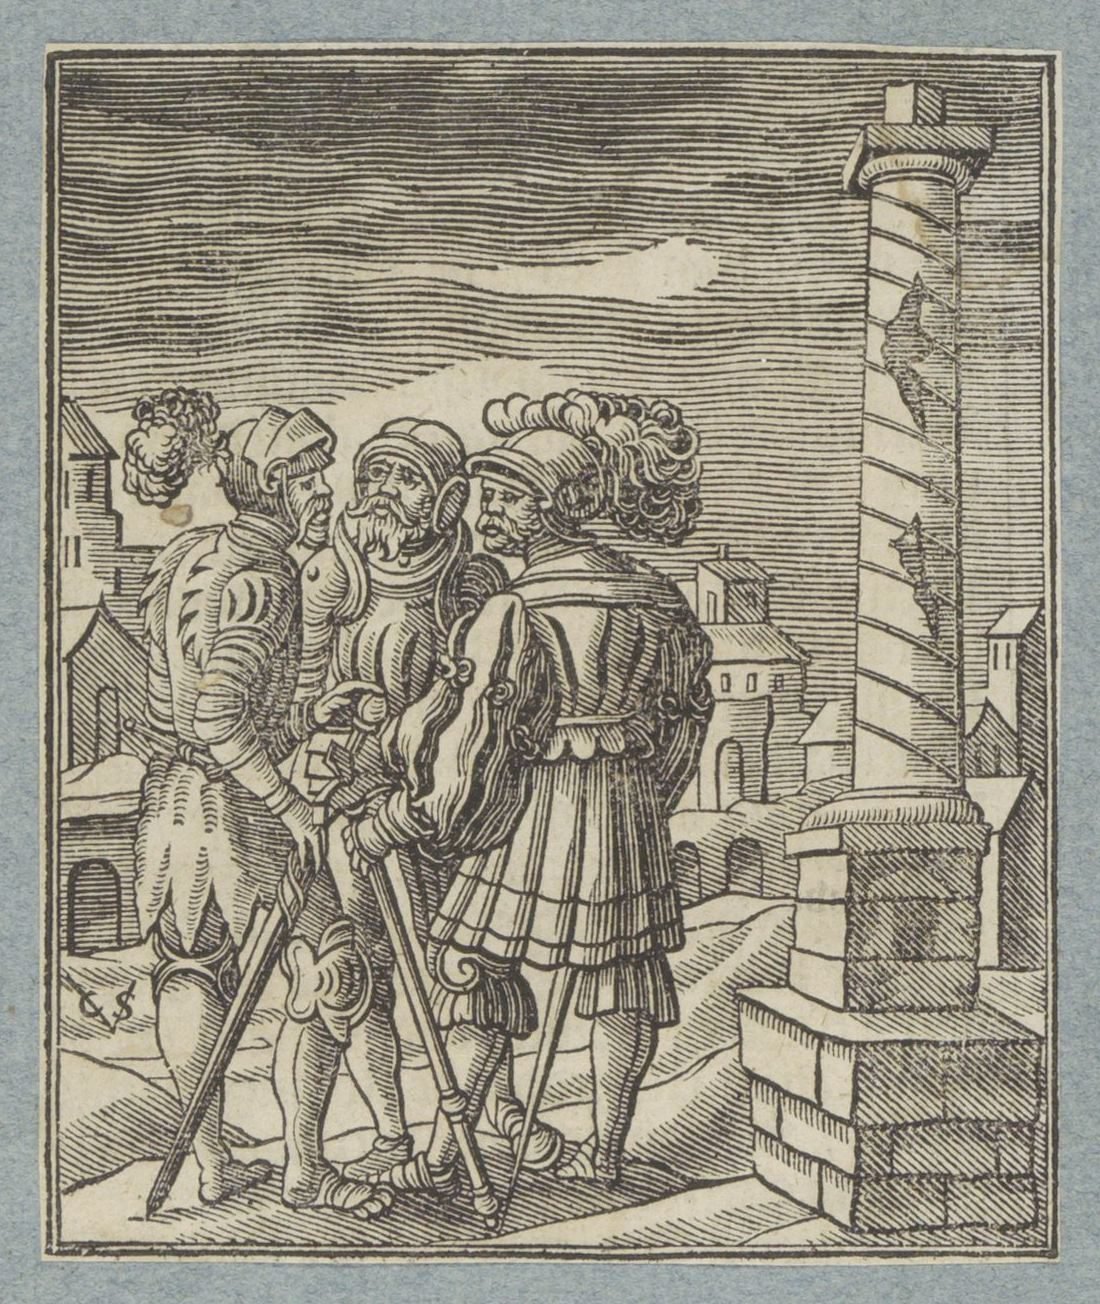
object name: book illustration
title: Overleg tussen drie krijgslieden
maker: pieter jacobsz. paets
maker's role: publisher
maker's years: 1587-1667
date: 1645-1646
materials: paper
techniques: letterpress printing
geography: amsterdam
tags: judges 1-5, the israelites do evil again and are conquered by eglon, the king of moab, warfare; military affairs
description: Drie krijgslieden met rechts een (triomf)zuil. Hier gebruikt als afbeelding van koning Eglon van Moab. Hij wist de Ammonieten en Amalkieten op zijn hand te krijgen. In opdracht van God de Vader versloeg hij Israël en maakten zich meester van de Palmstad. De Israëlieten moesten koning Eglon van Moab achttien jaar dienen. De prent maakt deel uit van een album.